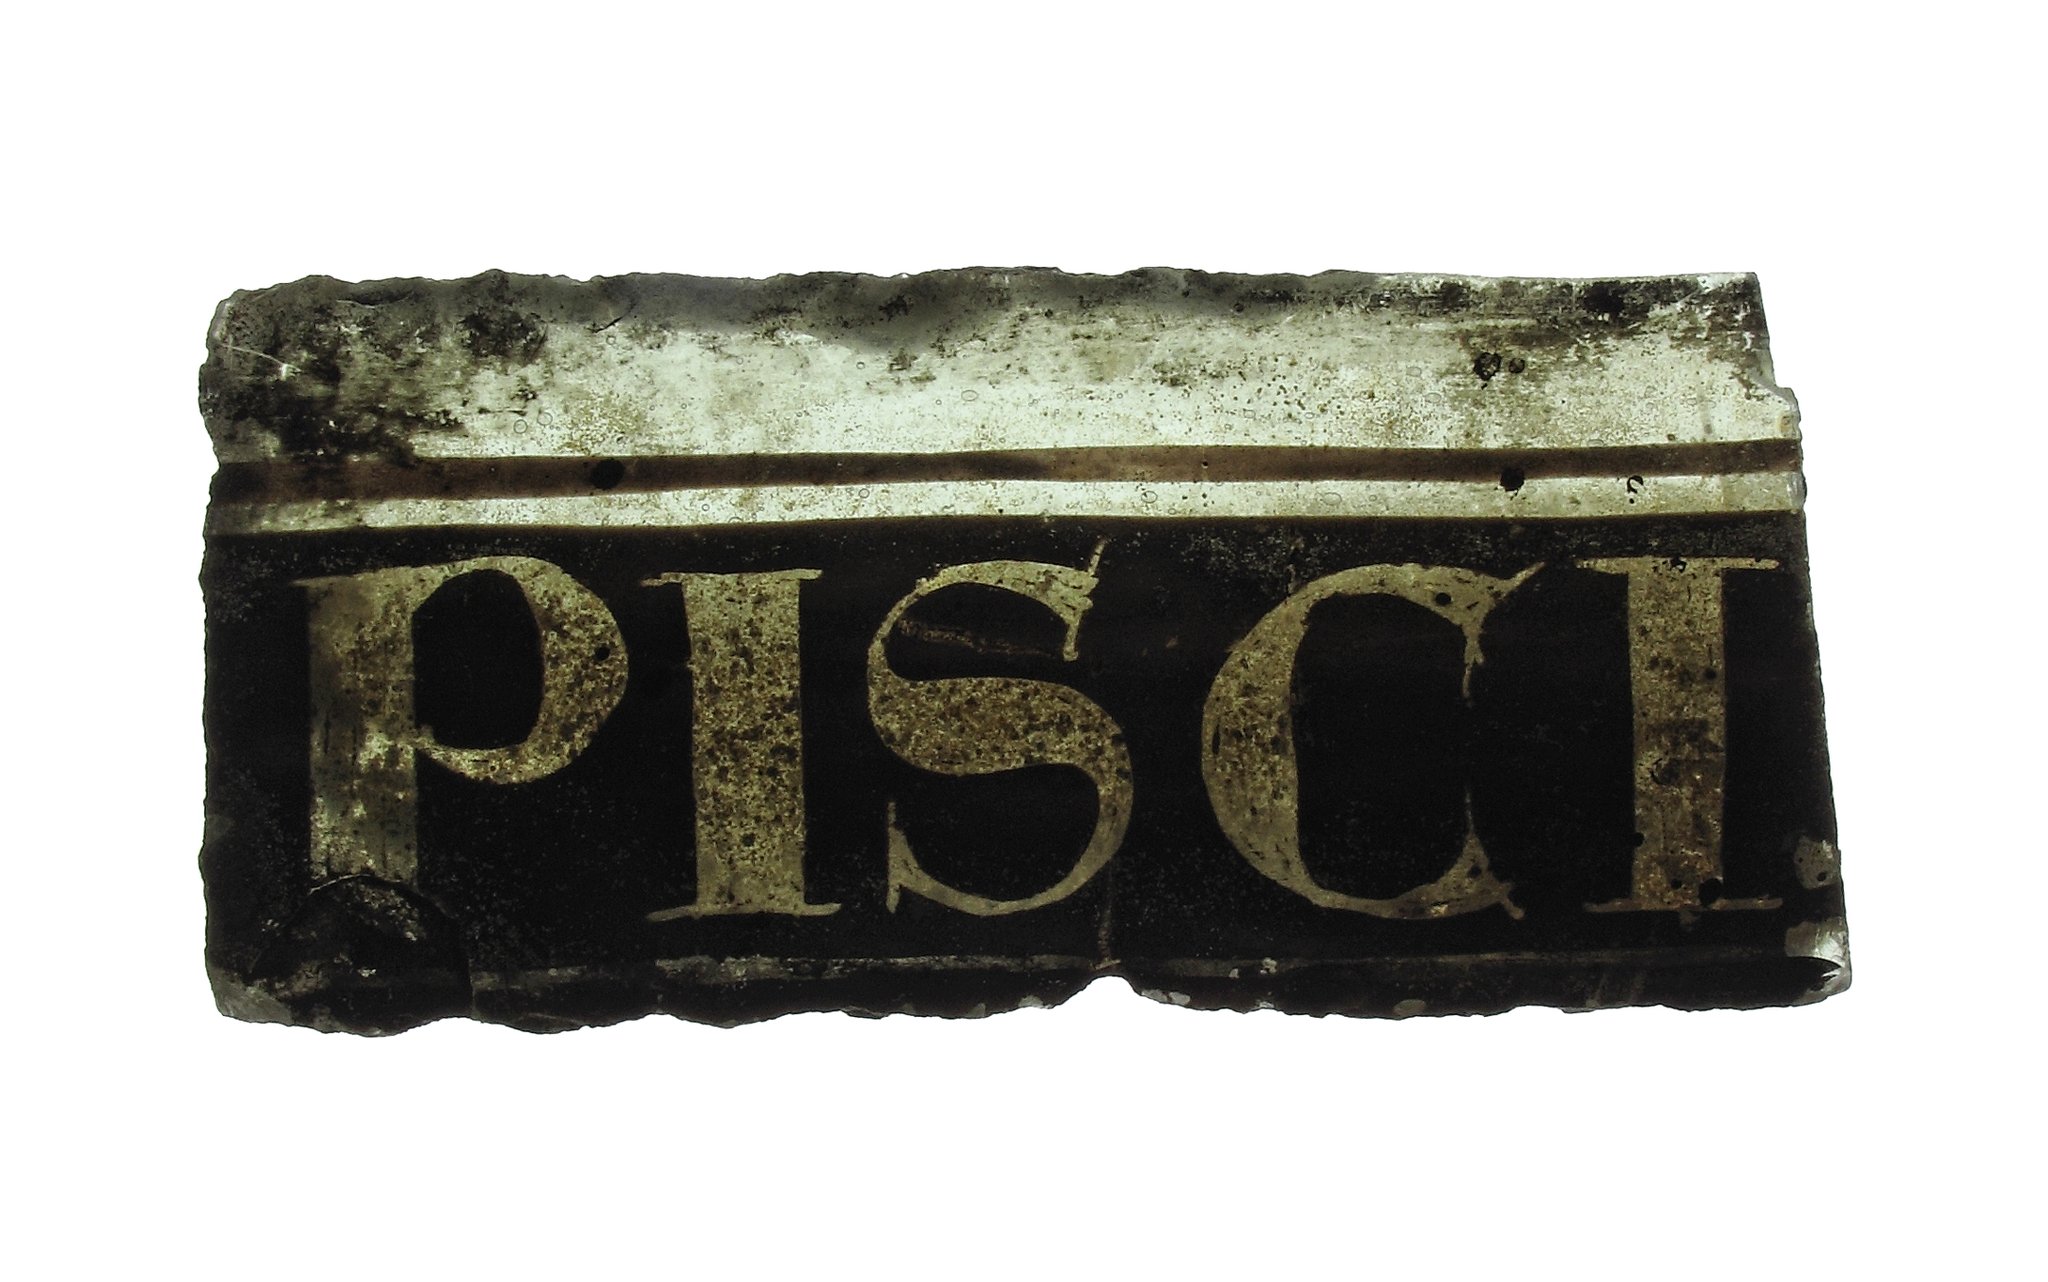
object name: fragment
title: Glass Fragment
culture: european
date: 1401-1500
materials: glass